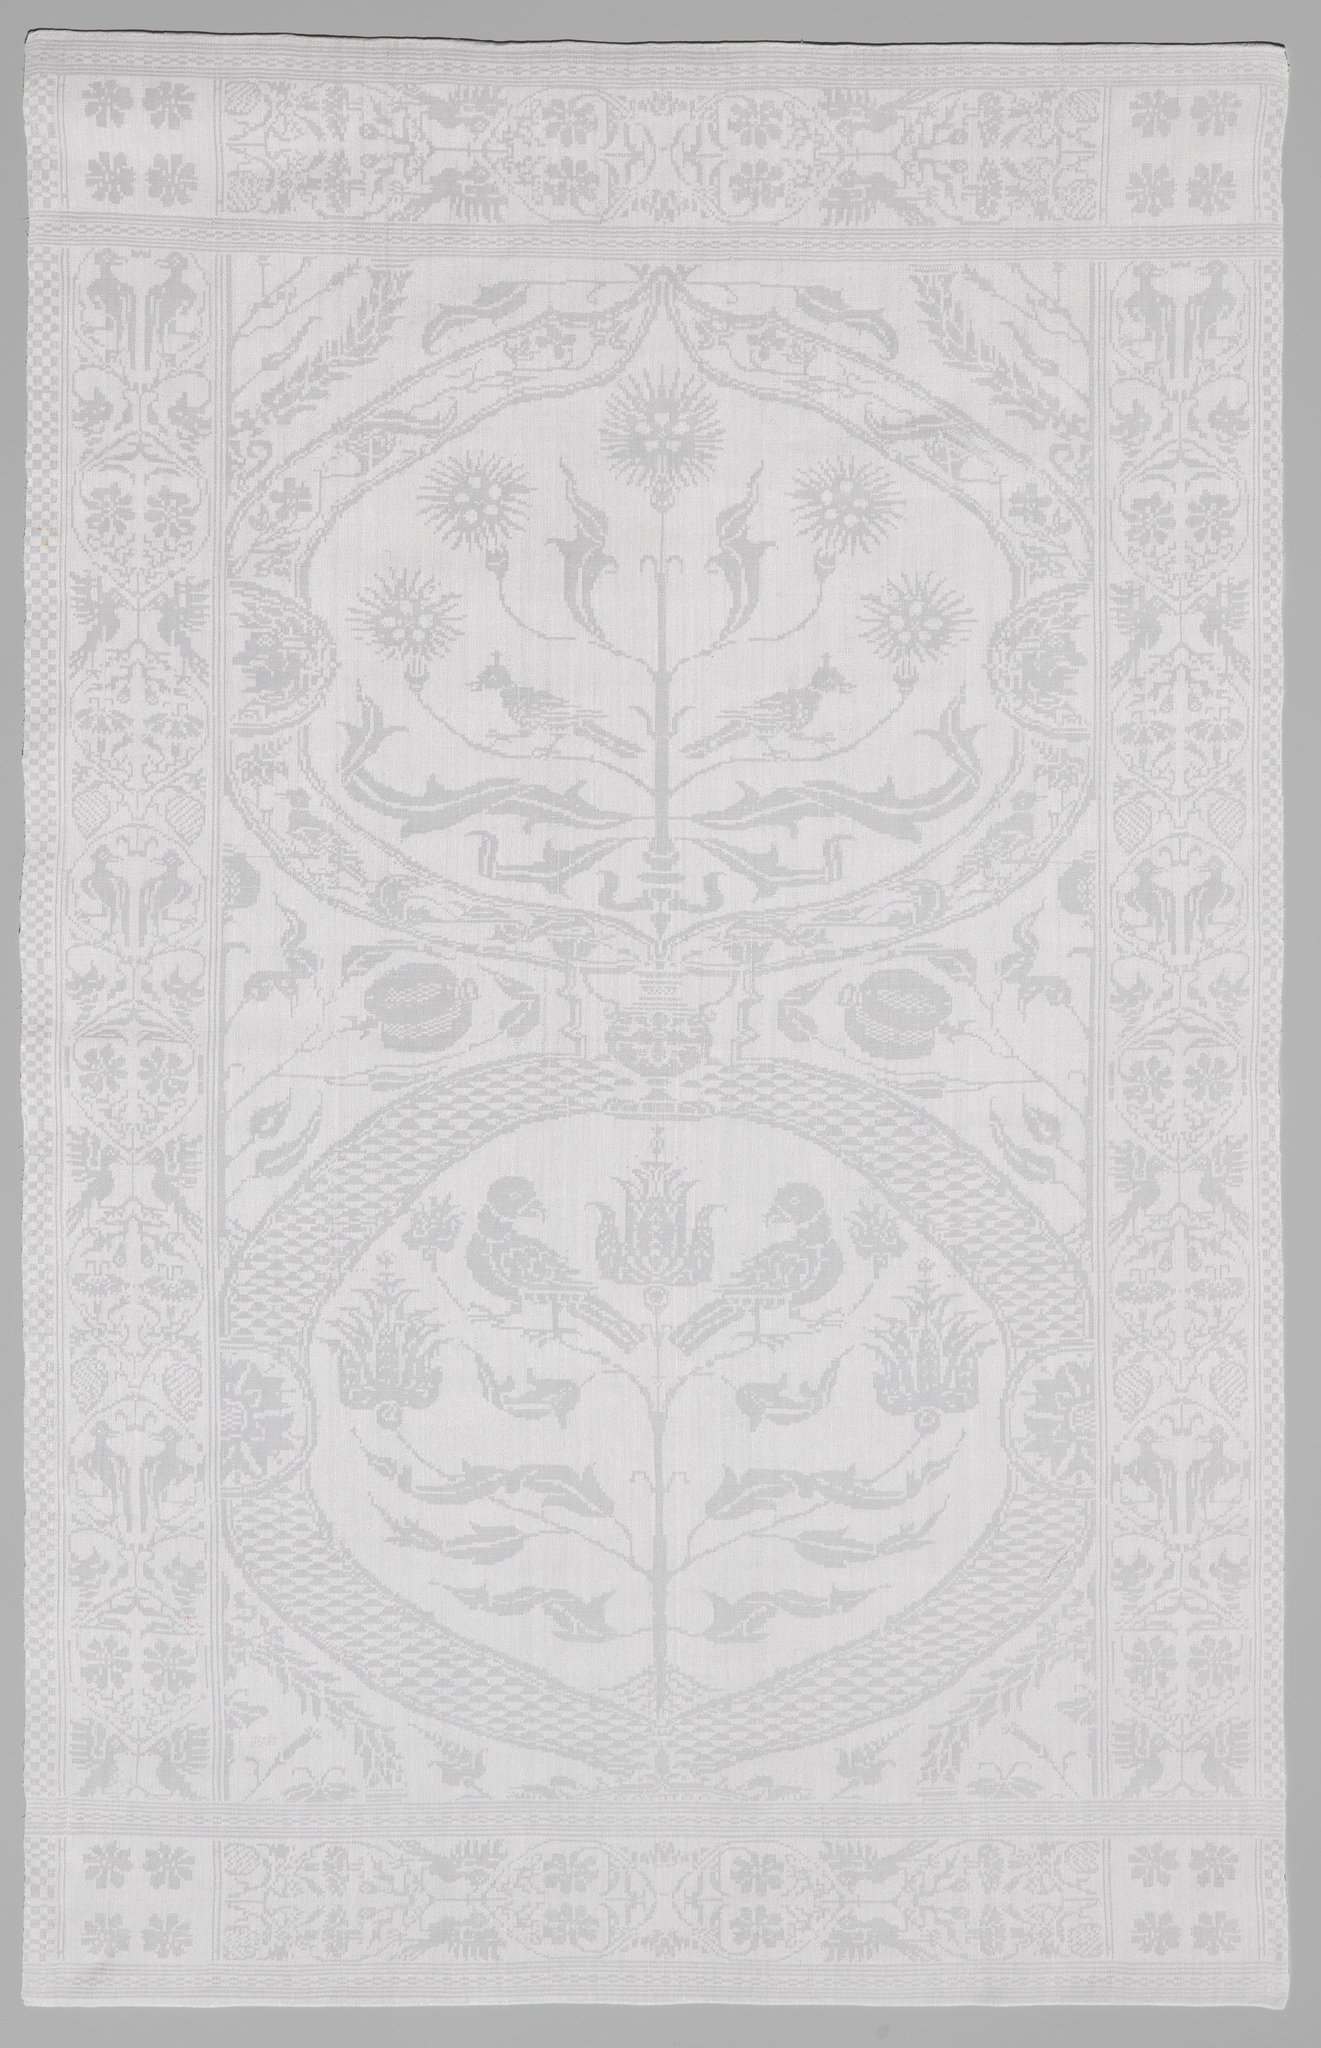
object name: napkin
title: Servet met vogels in kransen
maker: Anonymous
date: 1590-1610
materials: linen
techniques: damask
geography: haarlem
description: Middenveld: het patroon vertoont twee liggende ovale velden: 1 Omkranst met brede geschaakte band met links en rechts een half knooppunt waarin rozet. Symmetrische binnentekening van een stengel met gezwenkte lancetbladeren met drie palmetbloemen en twee afgewende papegaaien met toegewende koppen. 2 Verbonden met veld 1 door een vaas; omkranst door een spitsovale band waarin takken en vogels. Links en rechts een gehalveerd knooppunt. Symmetrische binnentekening van een stam met lancetbladeren en als kandelaars gezwenkte zijarmen, waaraan zonnebloemen en waarop twee afgewende vogels. In de zwikken granaatappels en anjers in krans. De randen vertonen spitsovale ranken met symmetrisch herhaalde vogels, vruchten en bloemen. In de hoeken telkens vier rozetten. Langs de staande randen een blokkenrand. Liggende randen gevat in zomen met streep en blokkenrand.